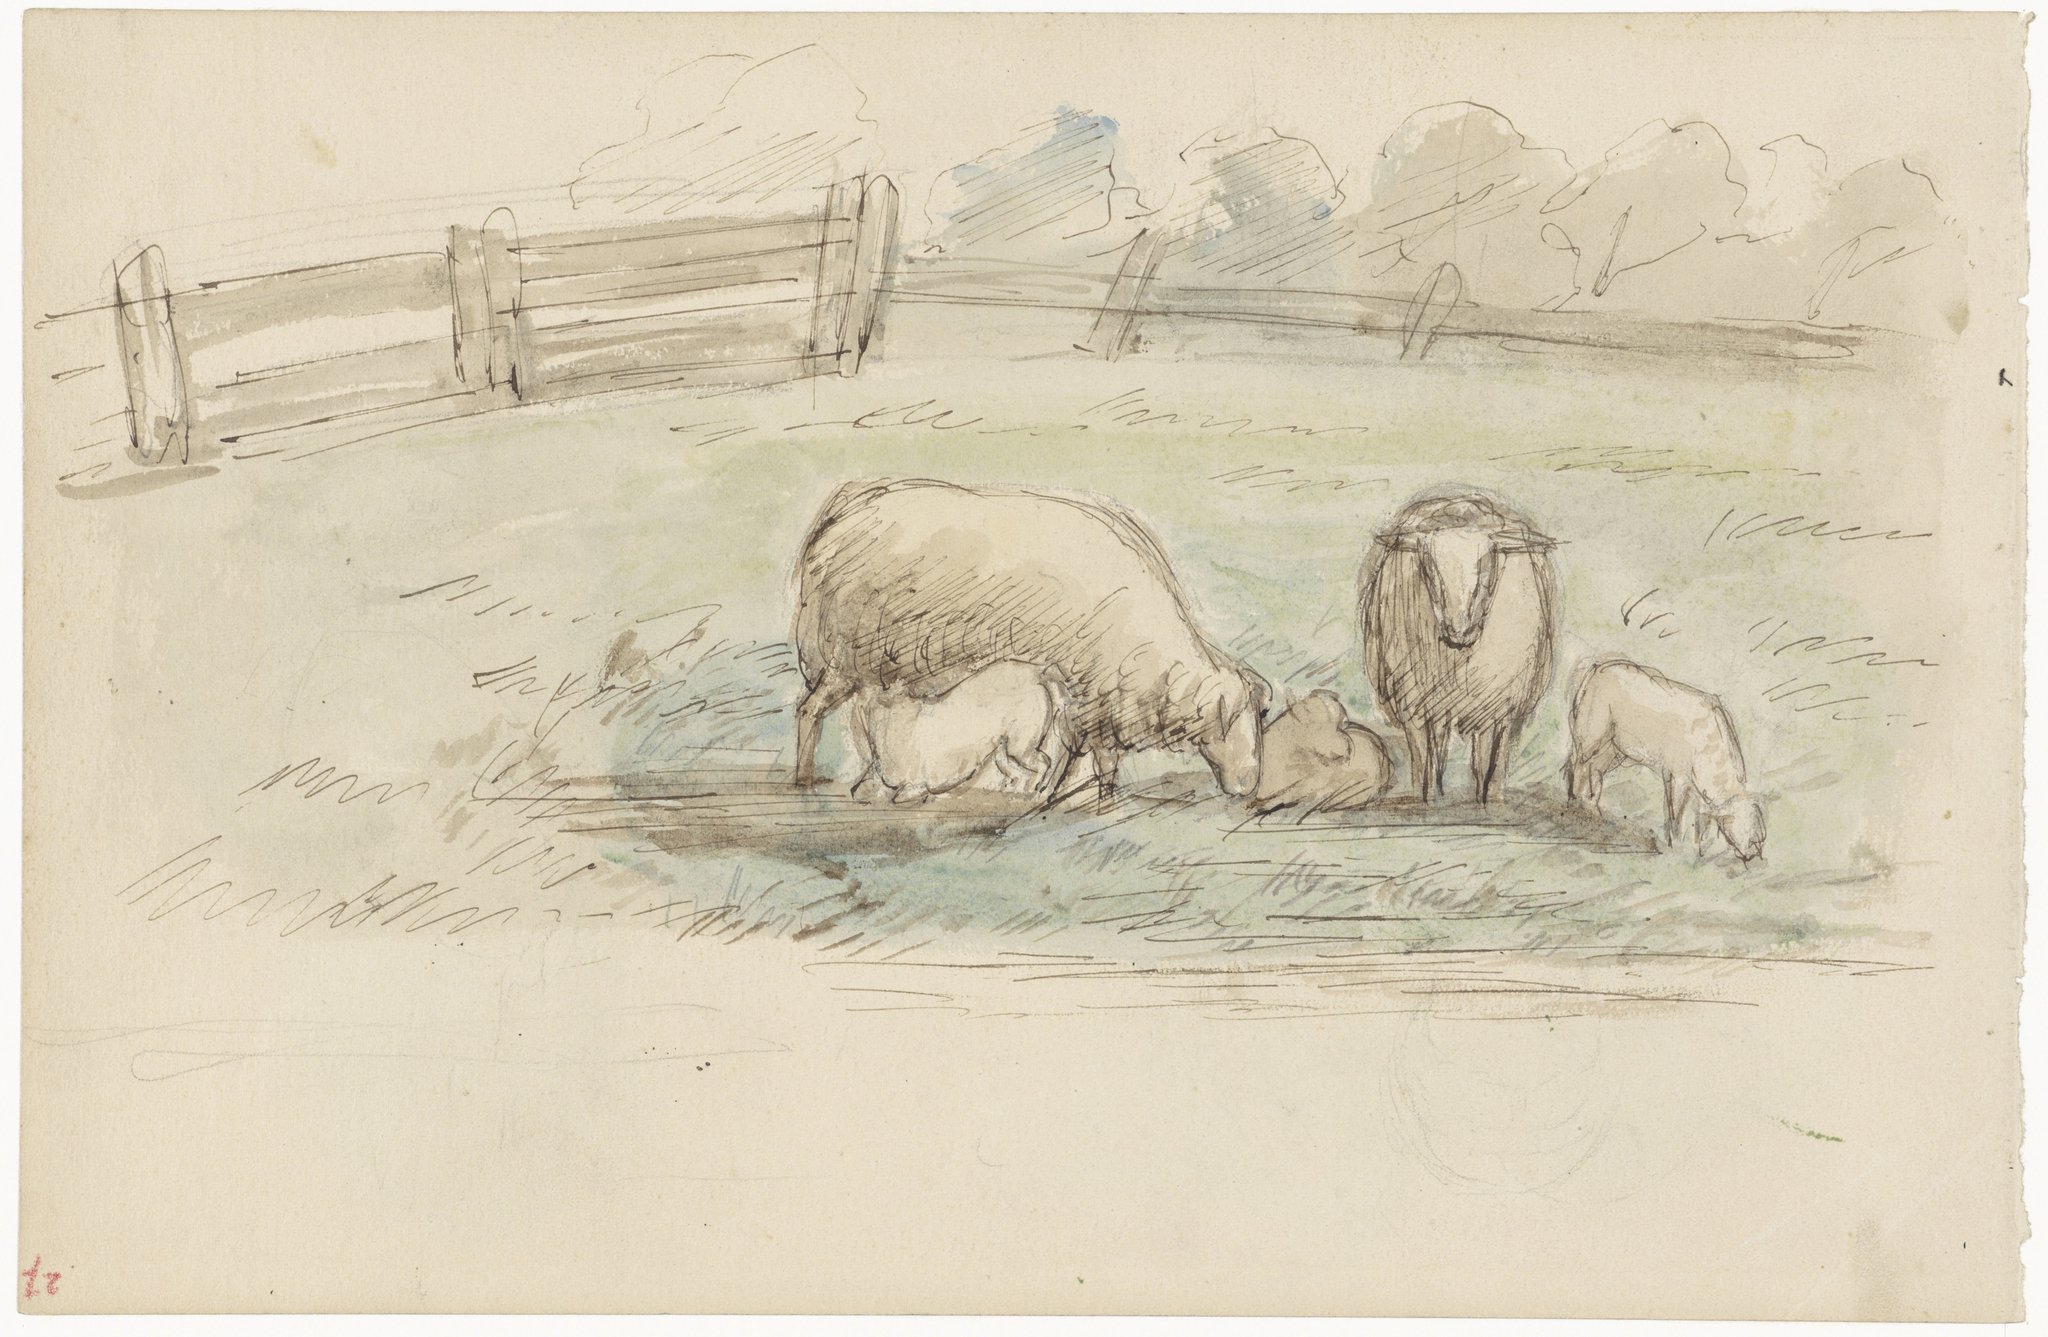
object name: watercolor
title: Schapen in een weide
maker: jozef israëls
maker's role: draughtsman, painter, print maker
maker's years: 1824-1911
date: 1834-1911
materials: ink, paper, pencil, watercolor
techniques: brush, pen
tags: sheep